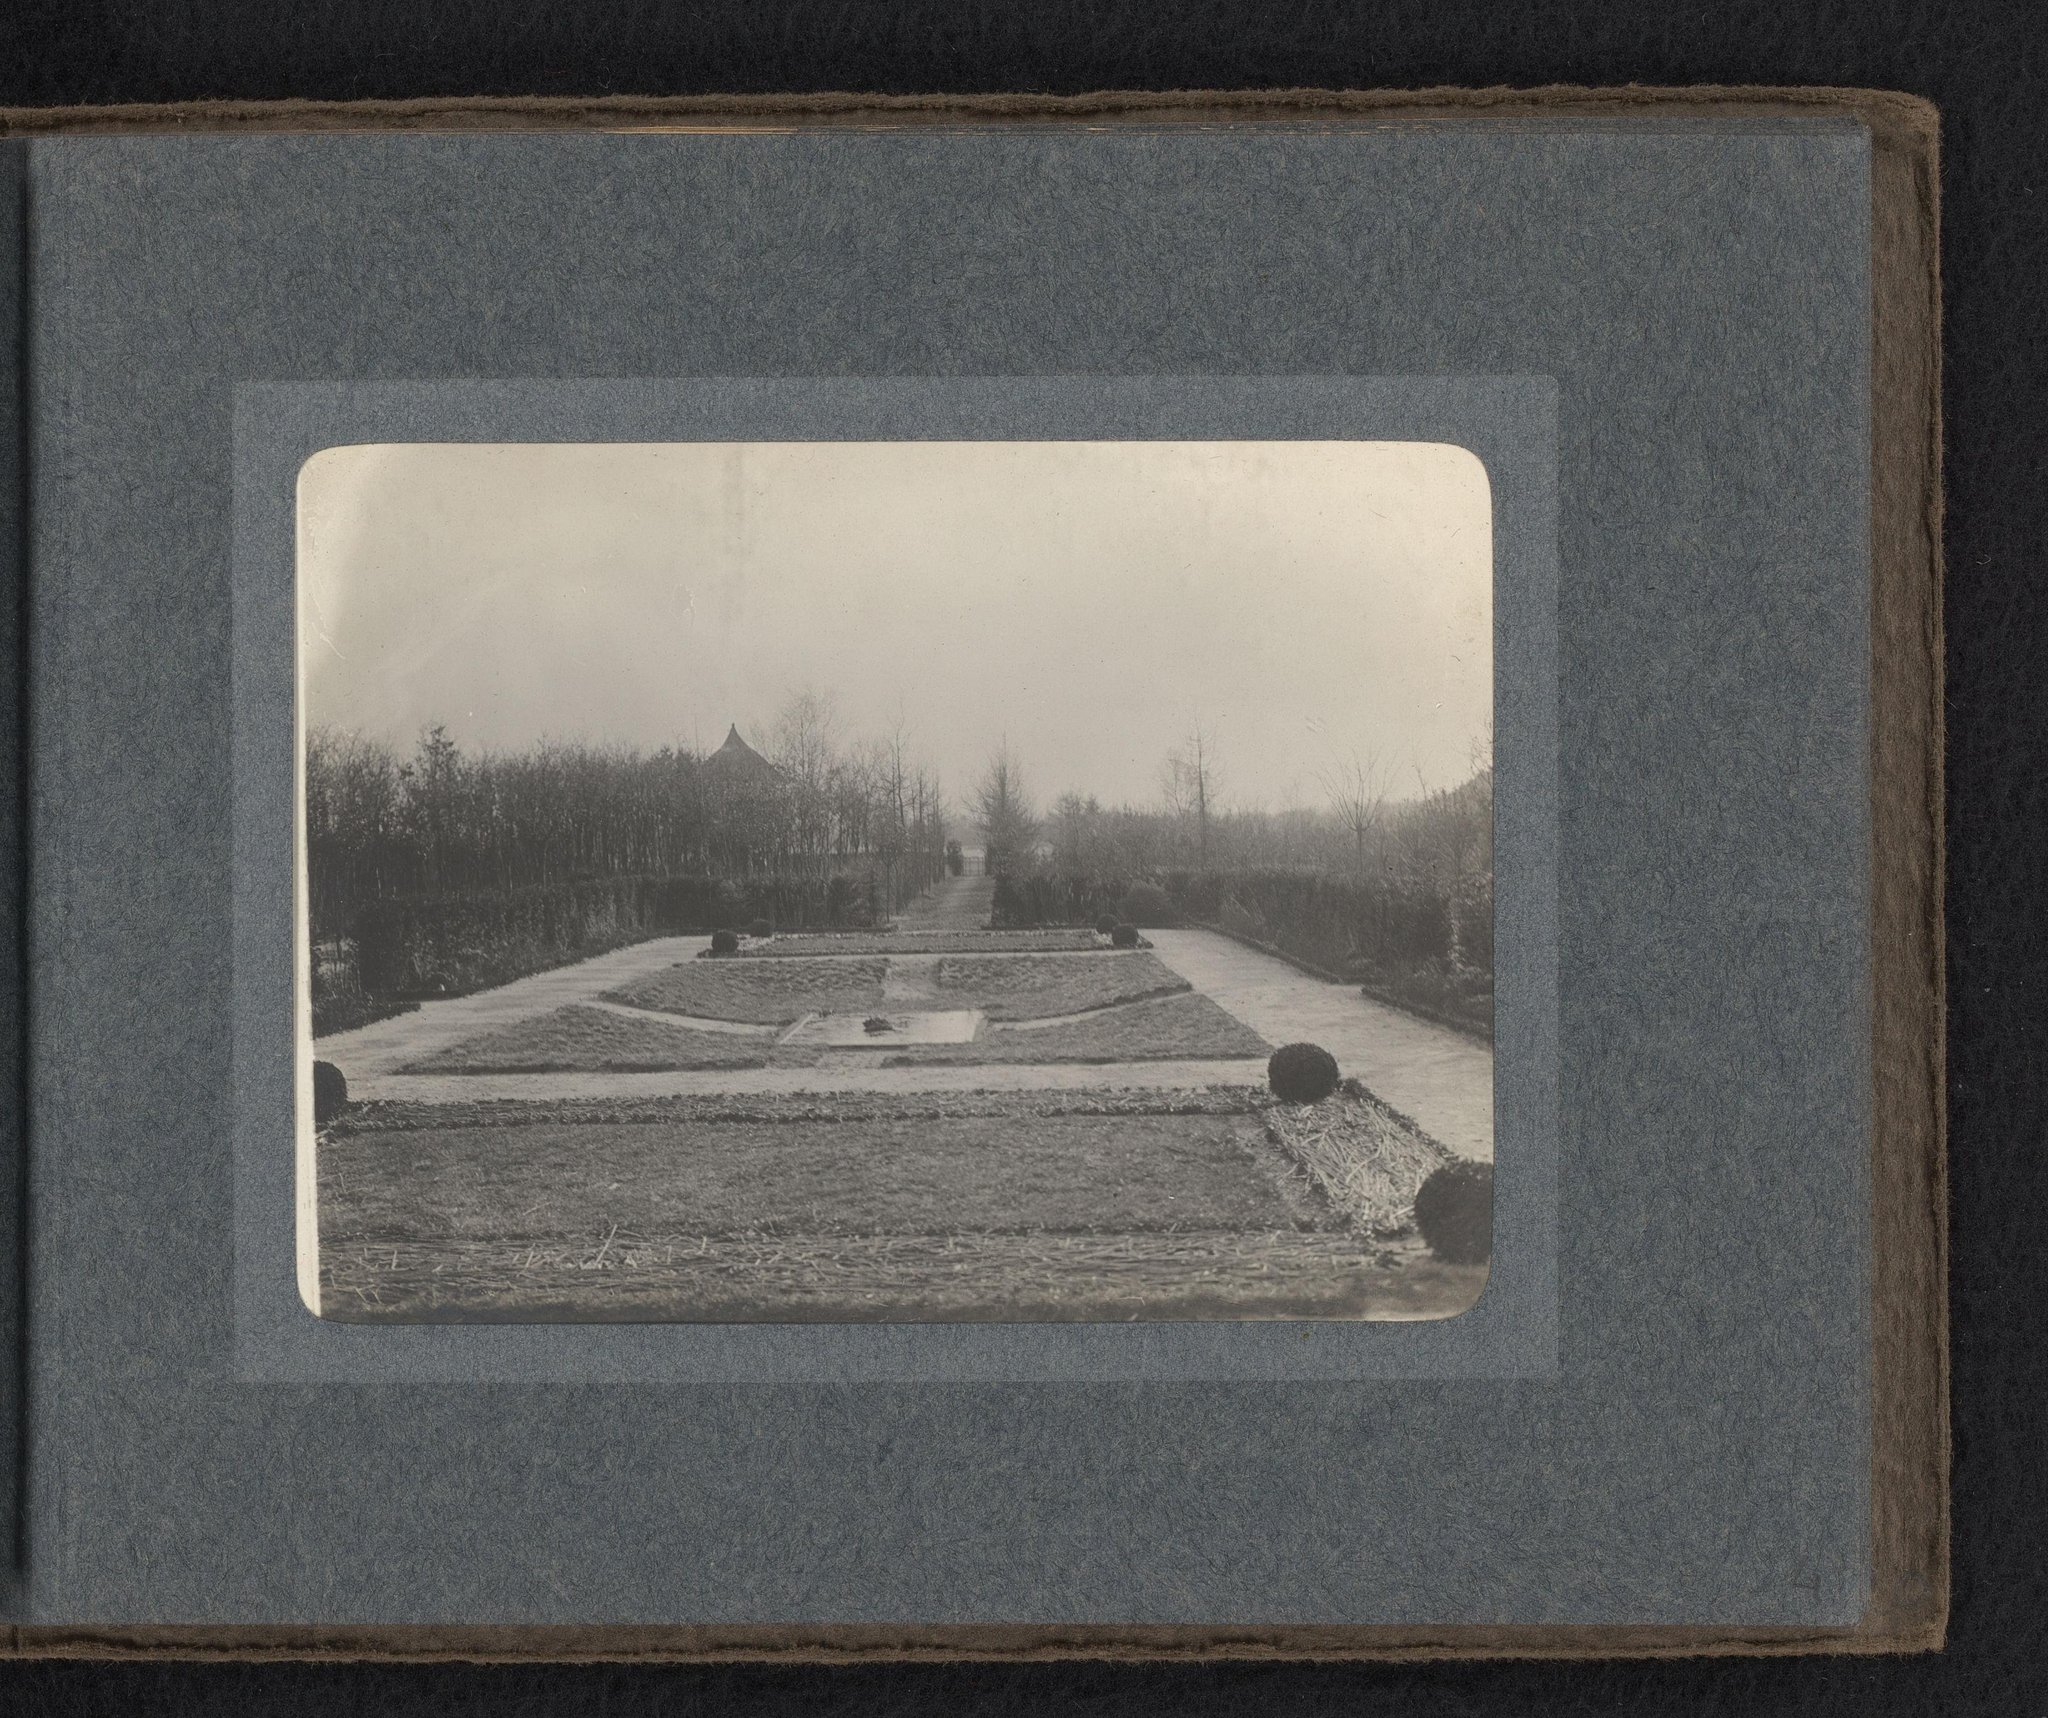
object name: album leaf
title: Tuin van een huis in Blaricum, gezien vanuit het huis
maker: hendrik herman van den berg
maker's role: amateurfotograaf, jurist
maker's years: 1875-1944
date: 1913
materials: paper, cardboard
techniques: gelatin silver print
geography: blaricum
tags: garden, village, villa